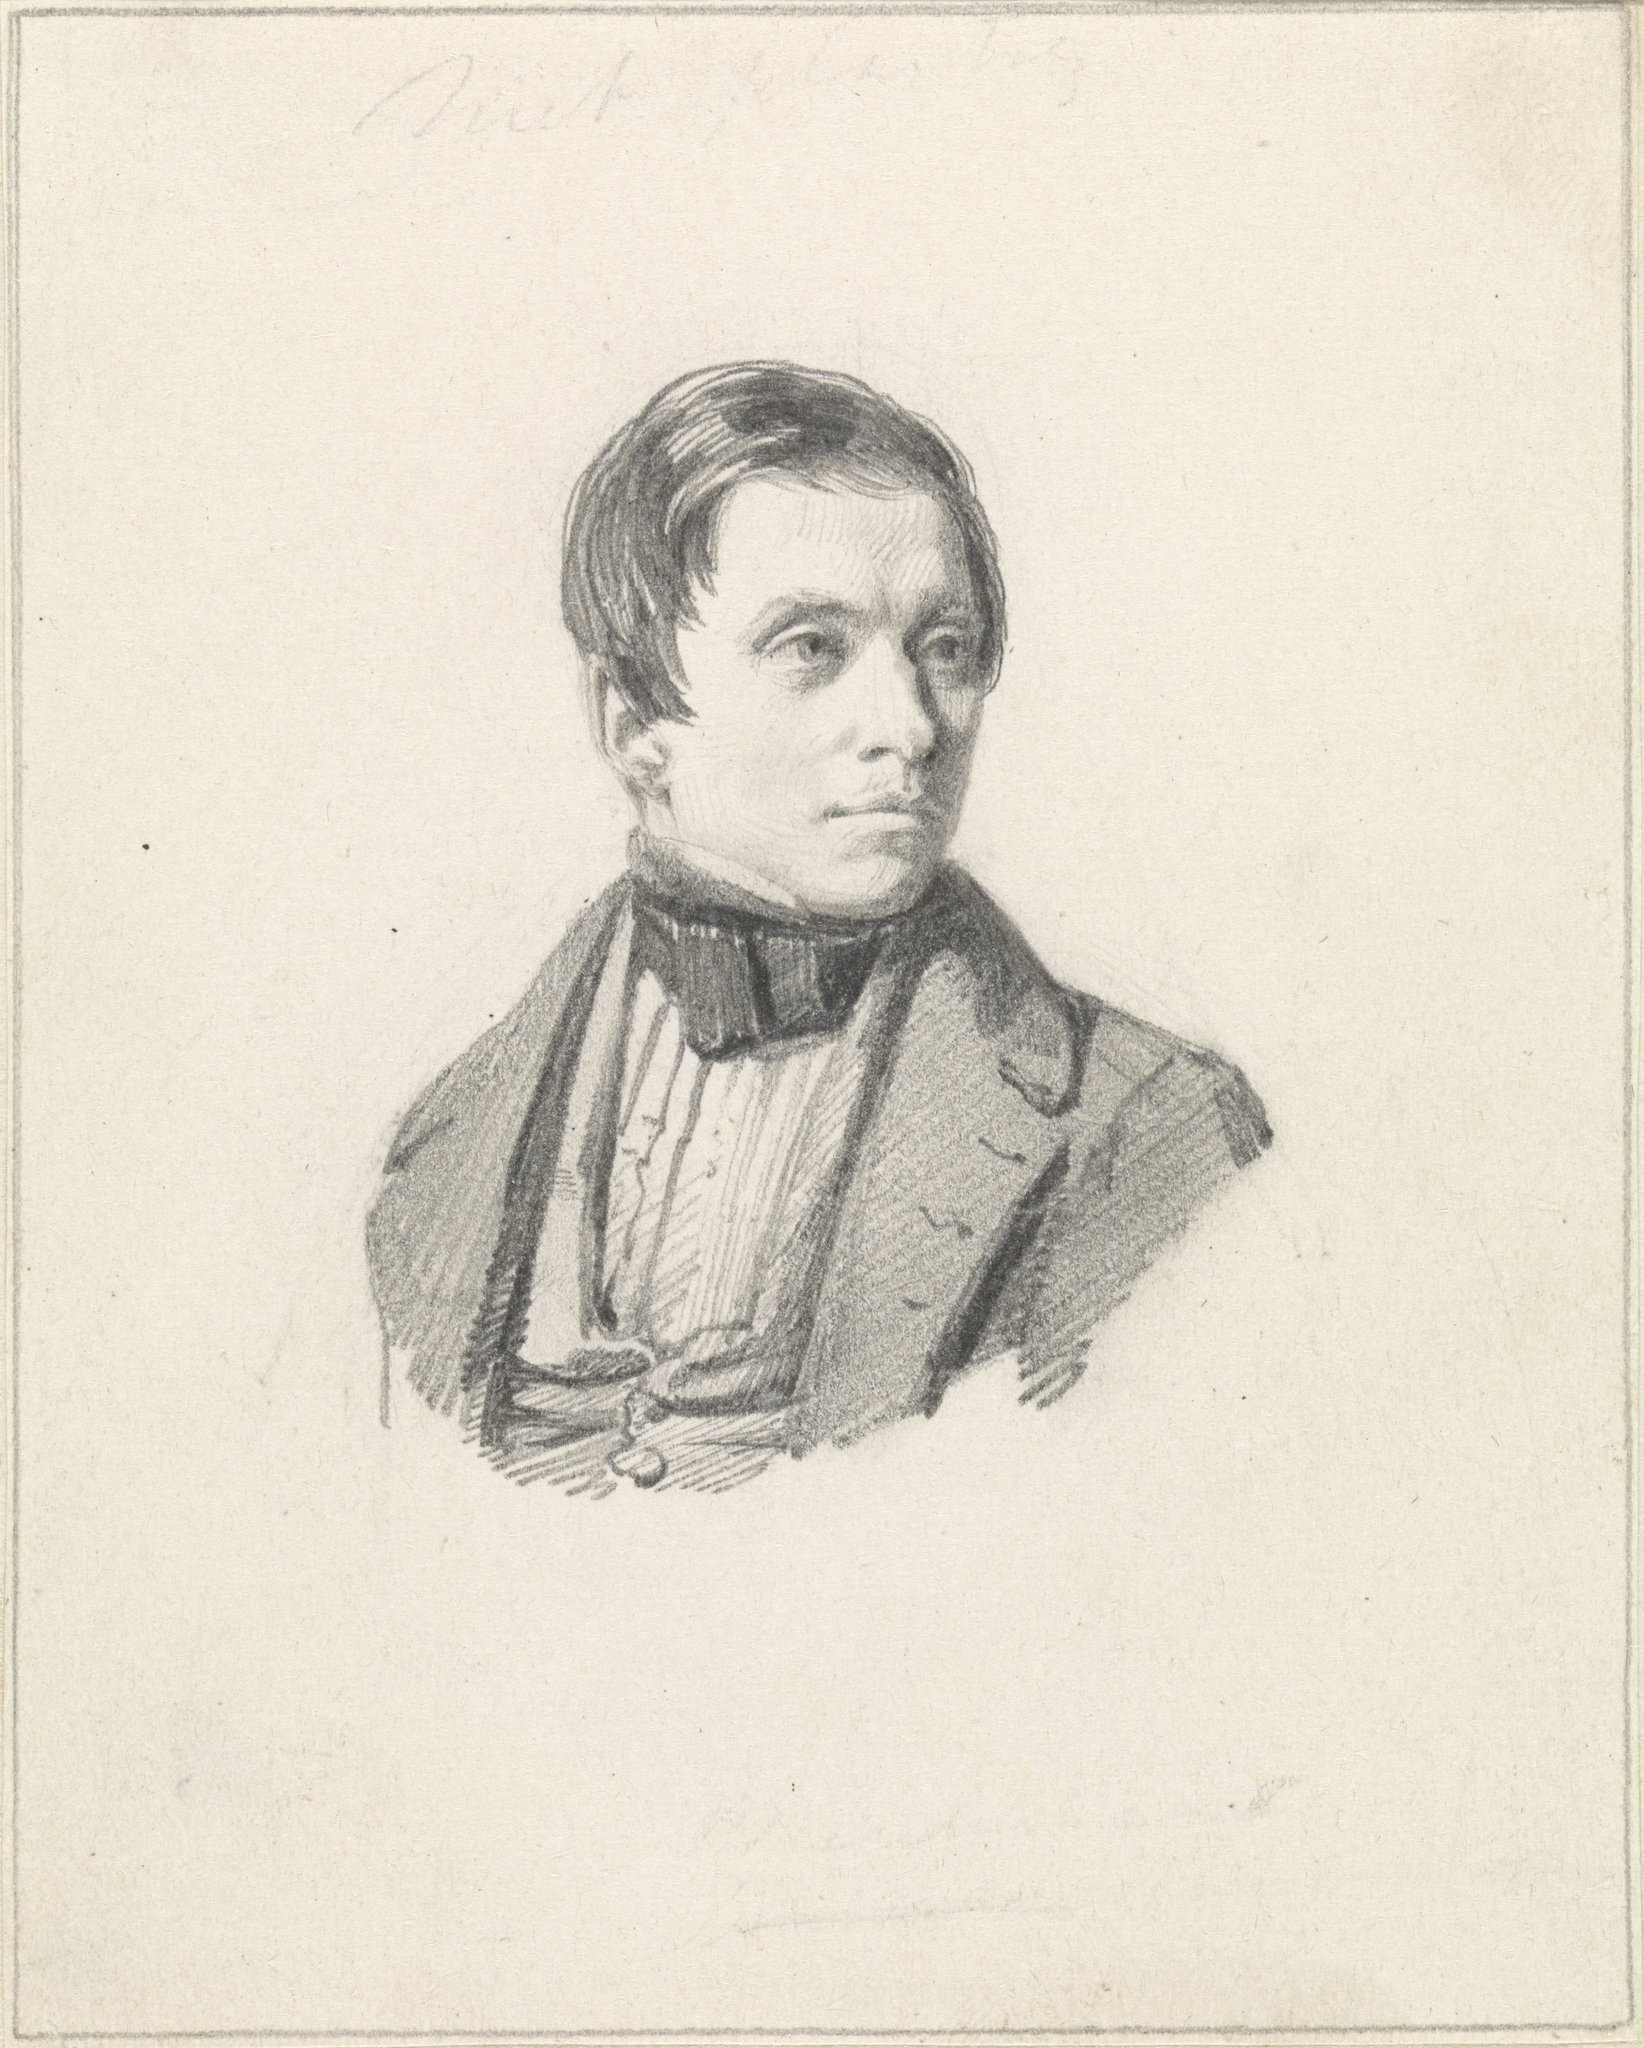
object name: design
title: Portret van Hendrik Breukelaar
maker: coenraad hamburger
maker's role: draughtsman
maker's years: 1809-1891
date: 1841-1842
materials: paper, pencil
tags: amsterdam, painter, draughtsman, hendrik breukelaar, historical persons, portrait, self-portrait of painter, portrait, self-portrait of artist, portrait, self-portrait of draughtsman